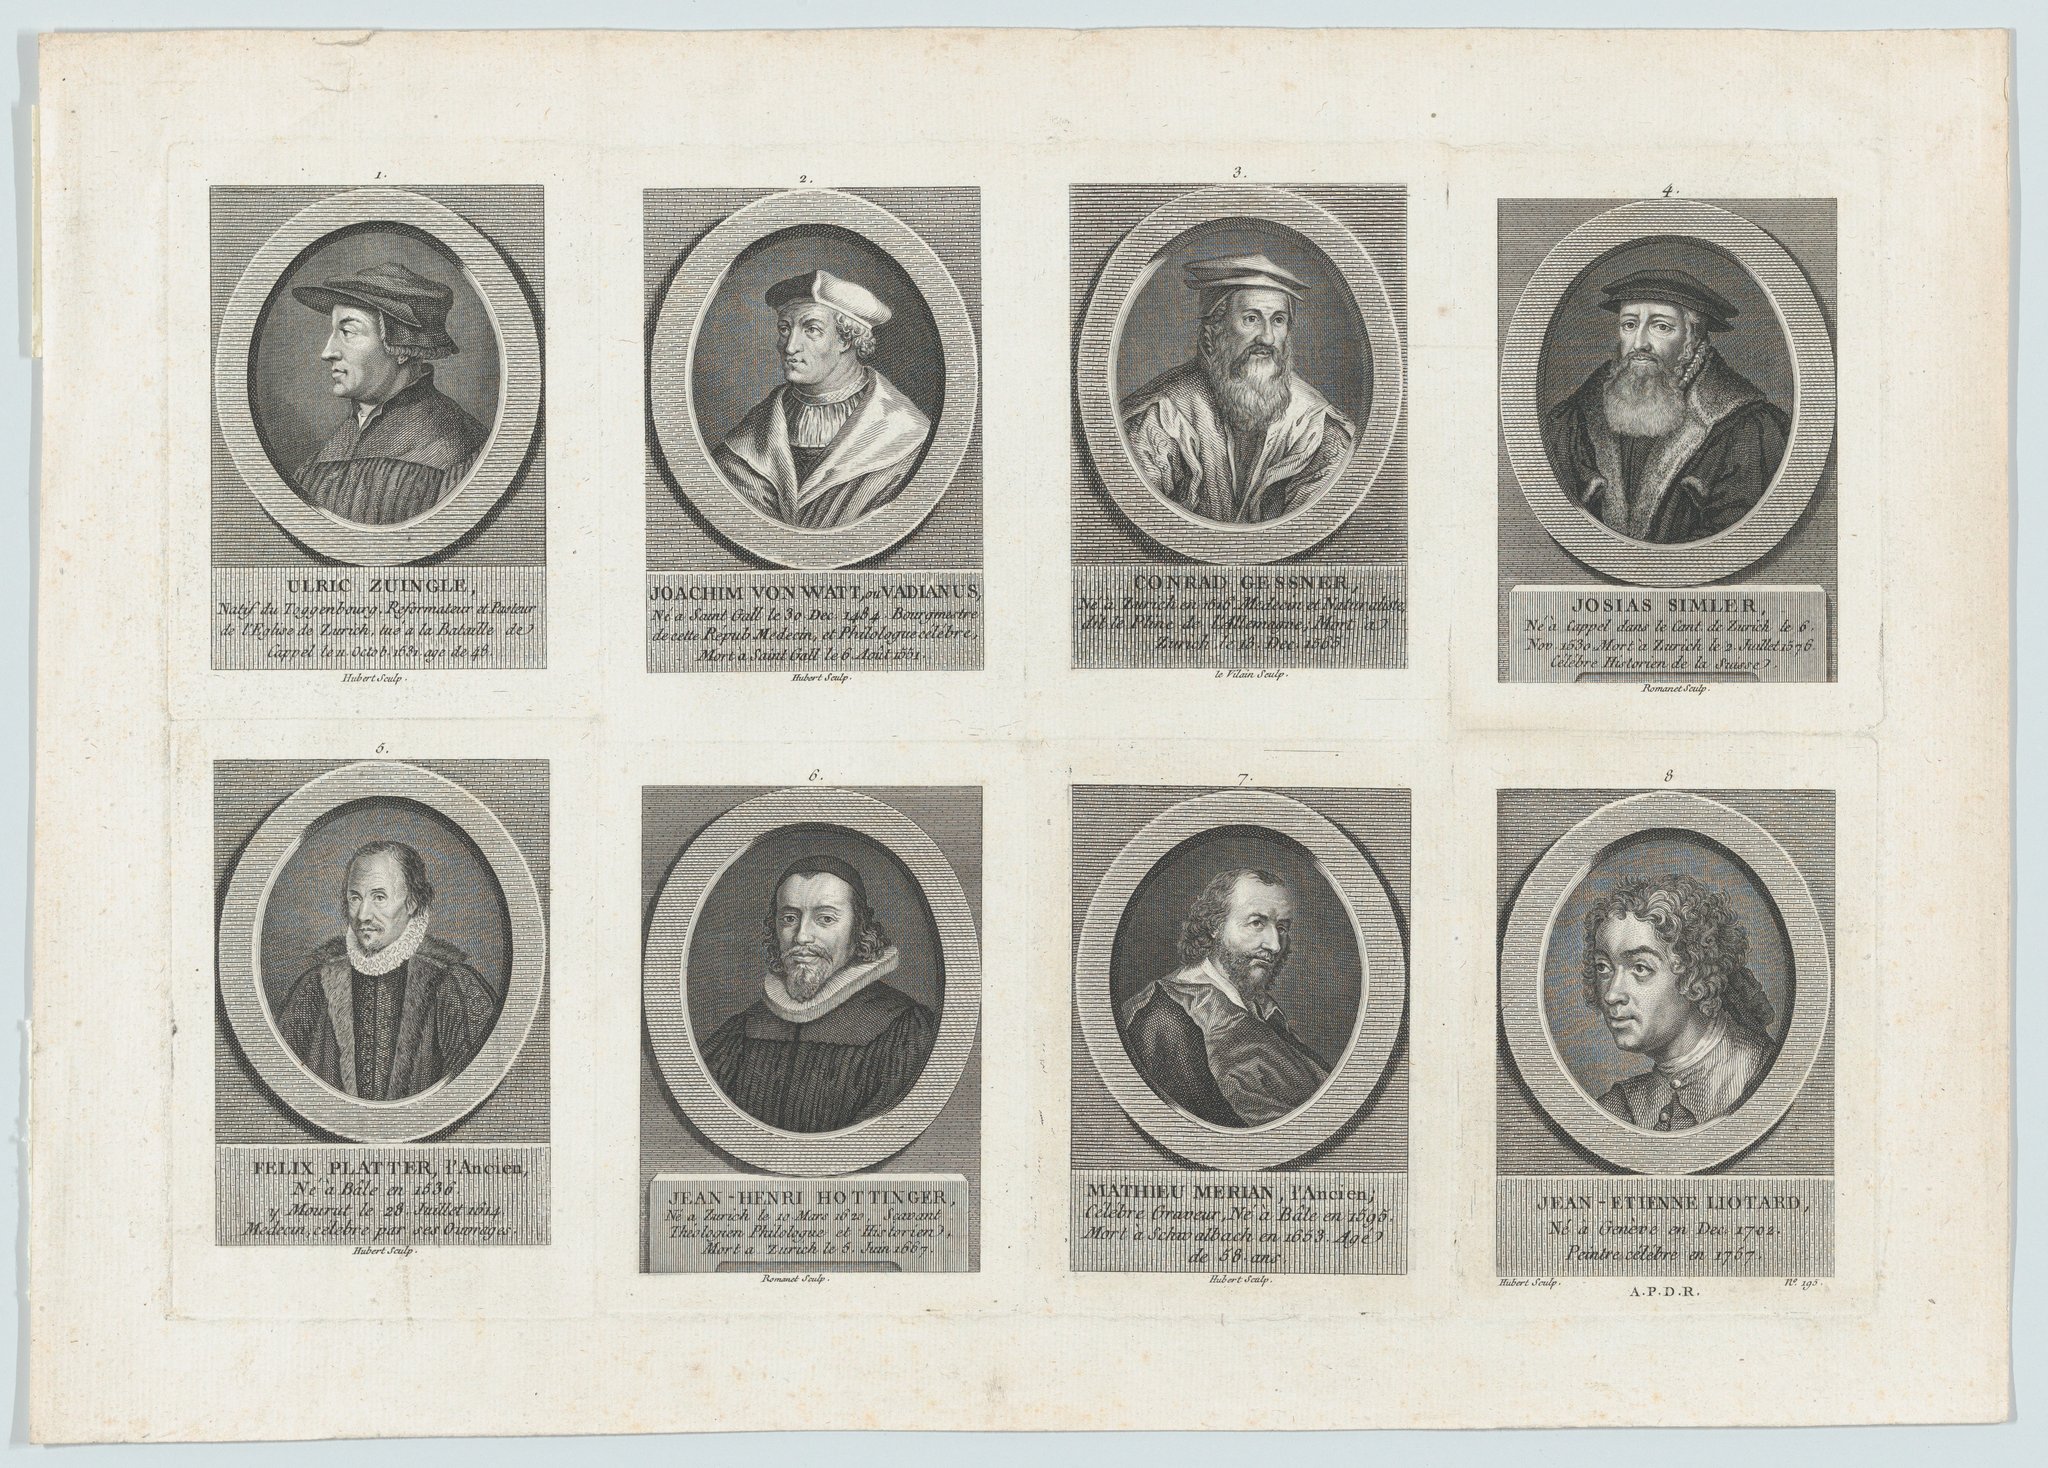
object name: print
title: Eight Portraits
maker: hubert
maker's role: artist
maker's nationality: french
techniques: engraving, etching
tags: men,portraits,profiles